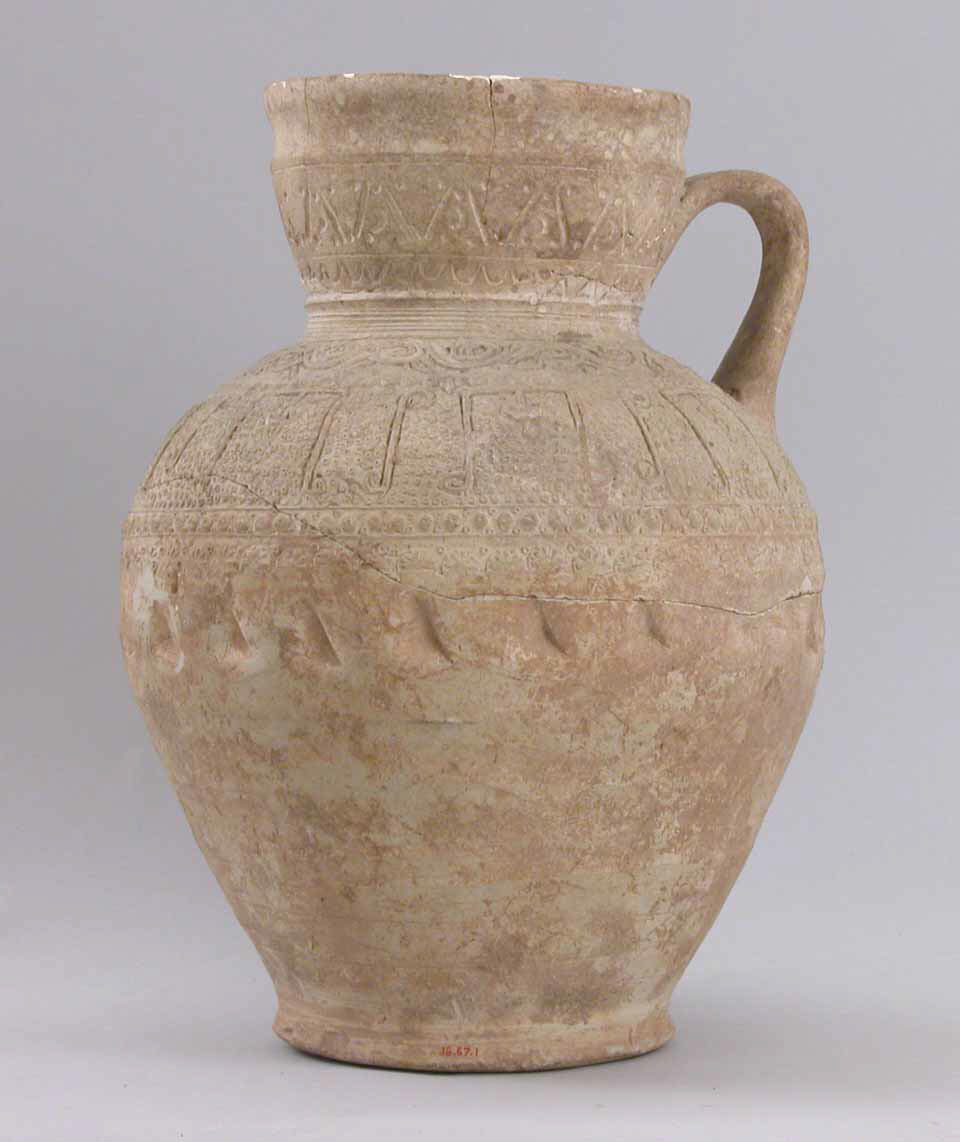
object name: jar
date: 1001-1100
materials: earthenware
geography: syria